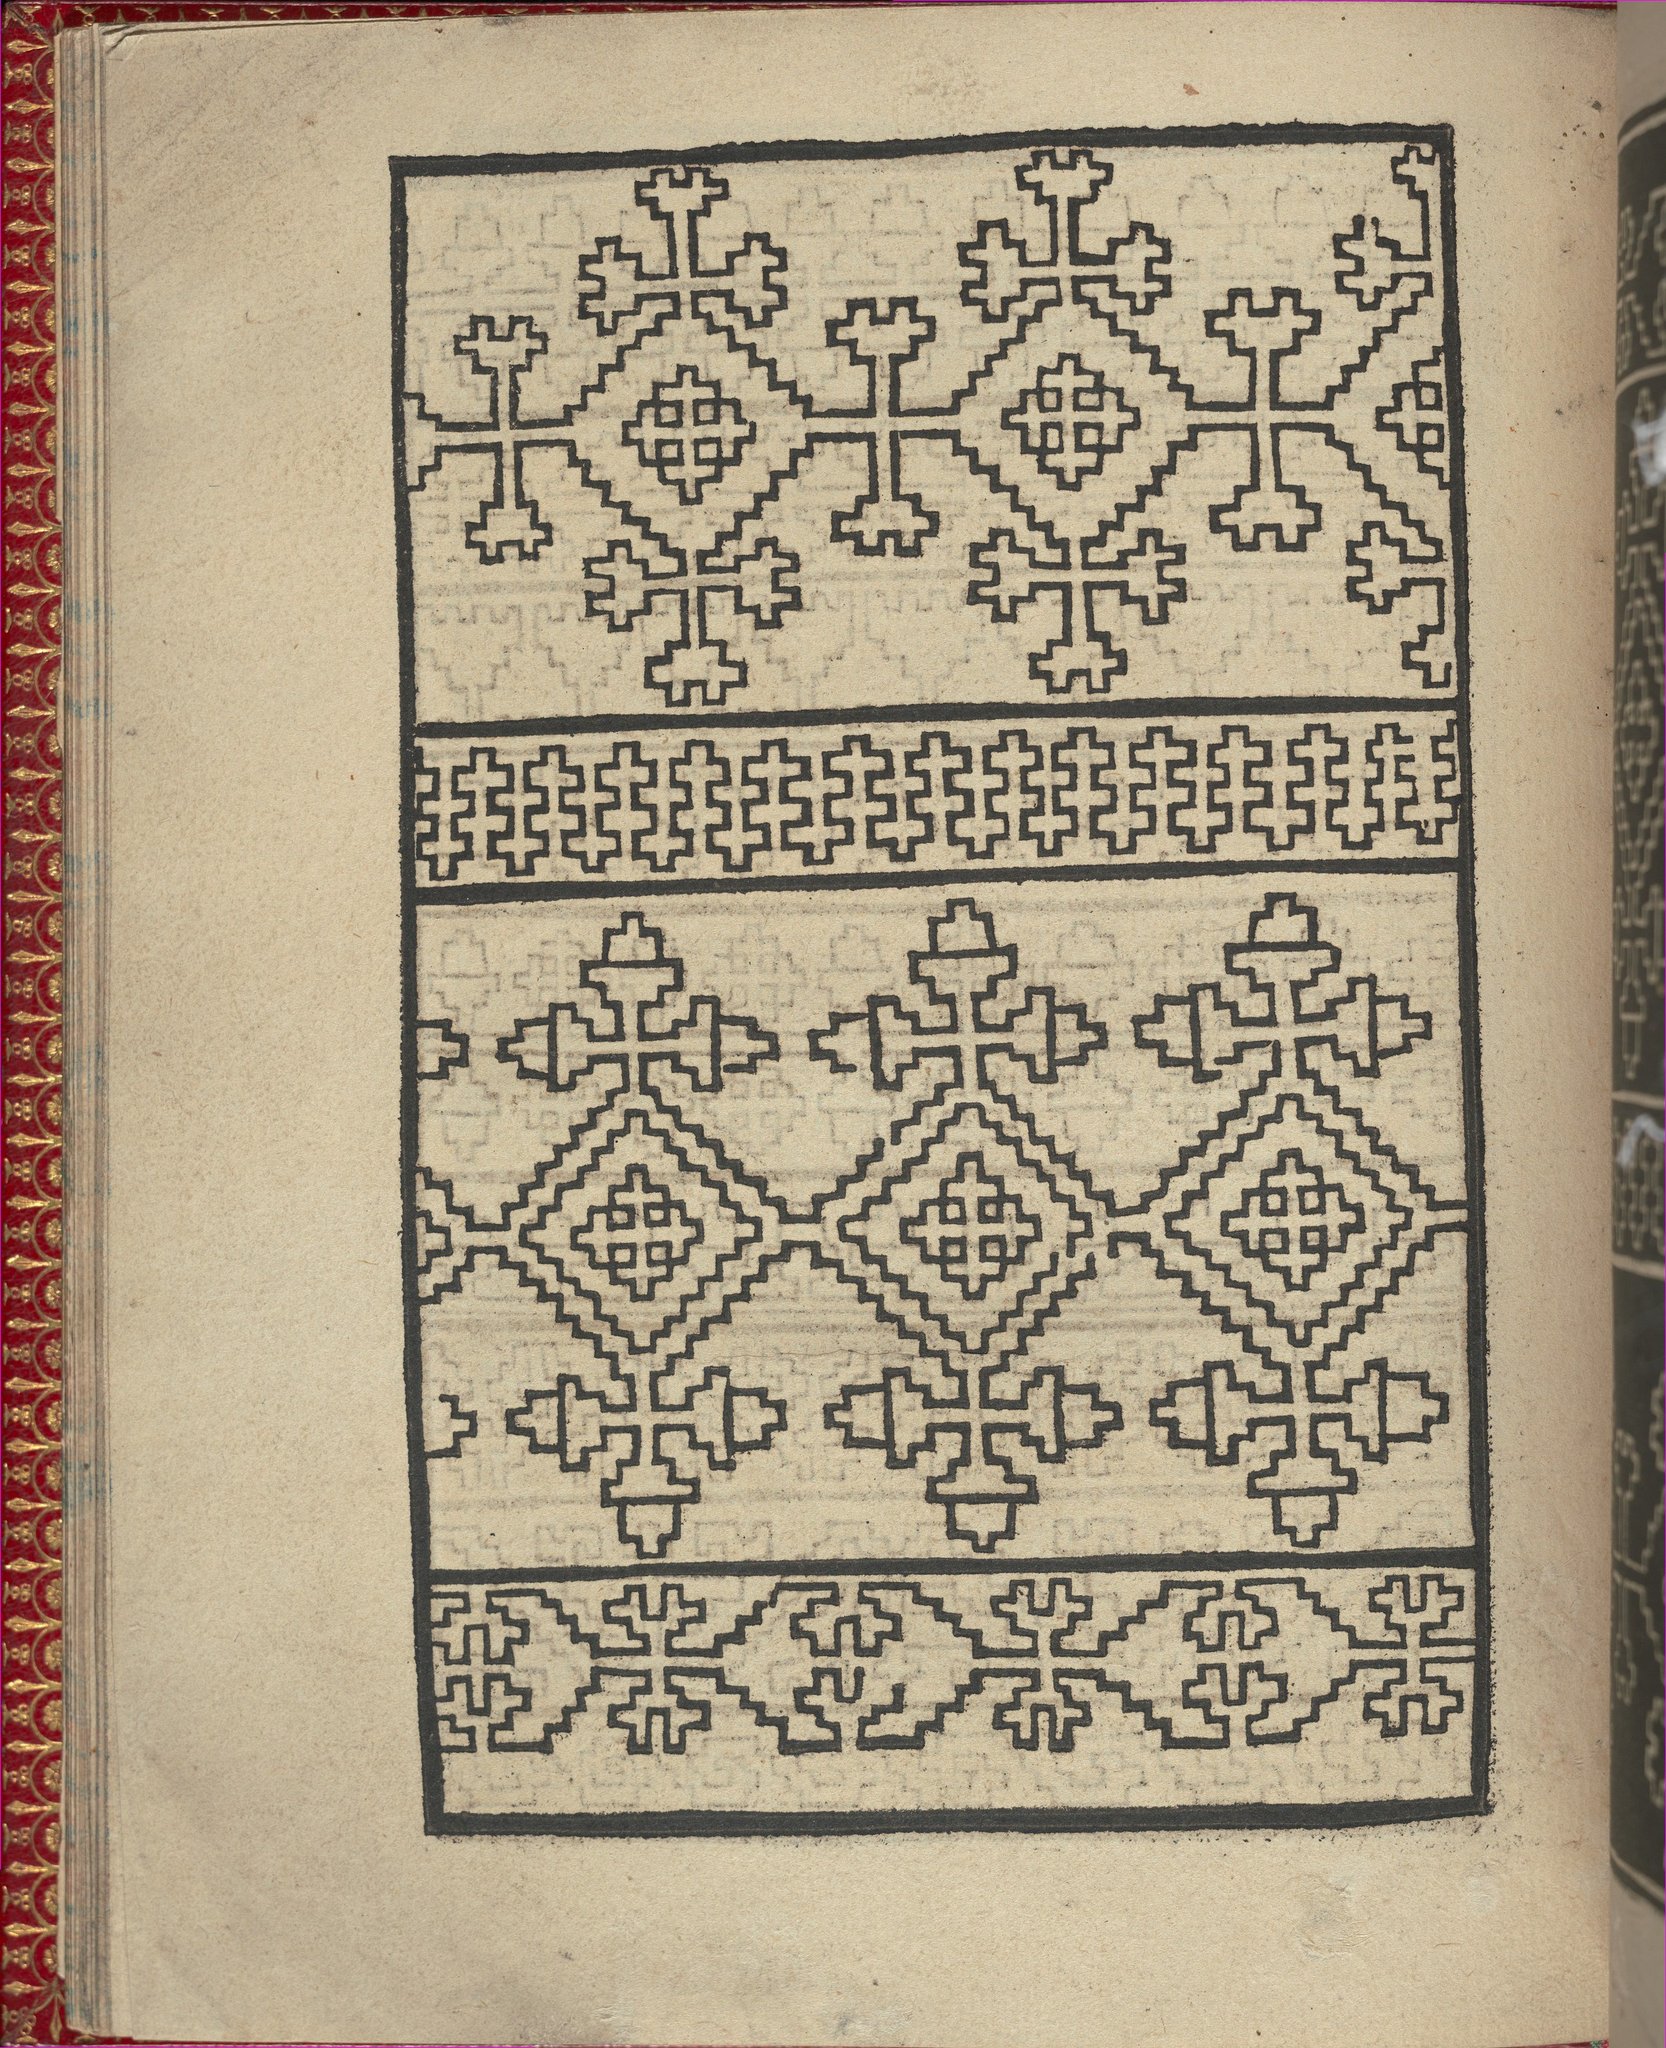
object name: book print ornament architecture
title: Ce est ung tractat de la noble art de leguille ascavoir ouvraiges de spaigne... page 11 (verso)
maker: willem vosterman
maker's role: printer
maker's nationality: netherlandish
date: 1527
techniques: woodcut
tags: ornament